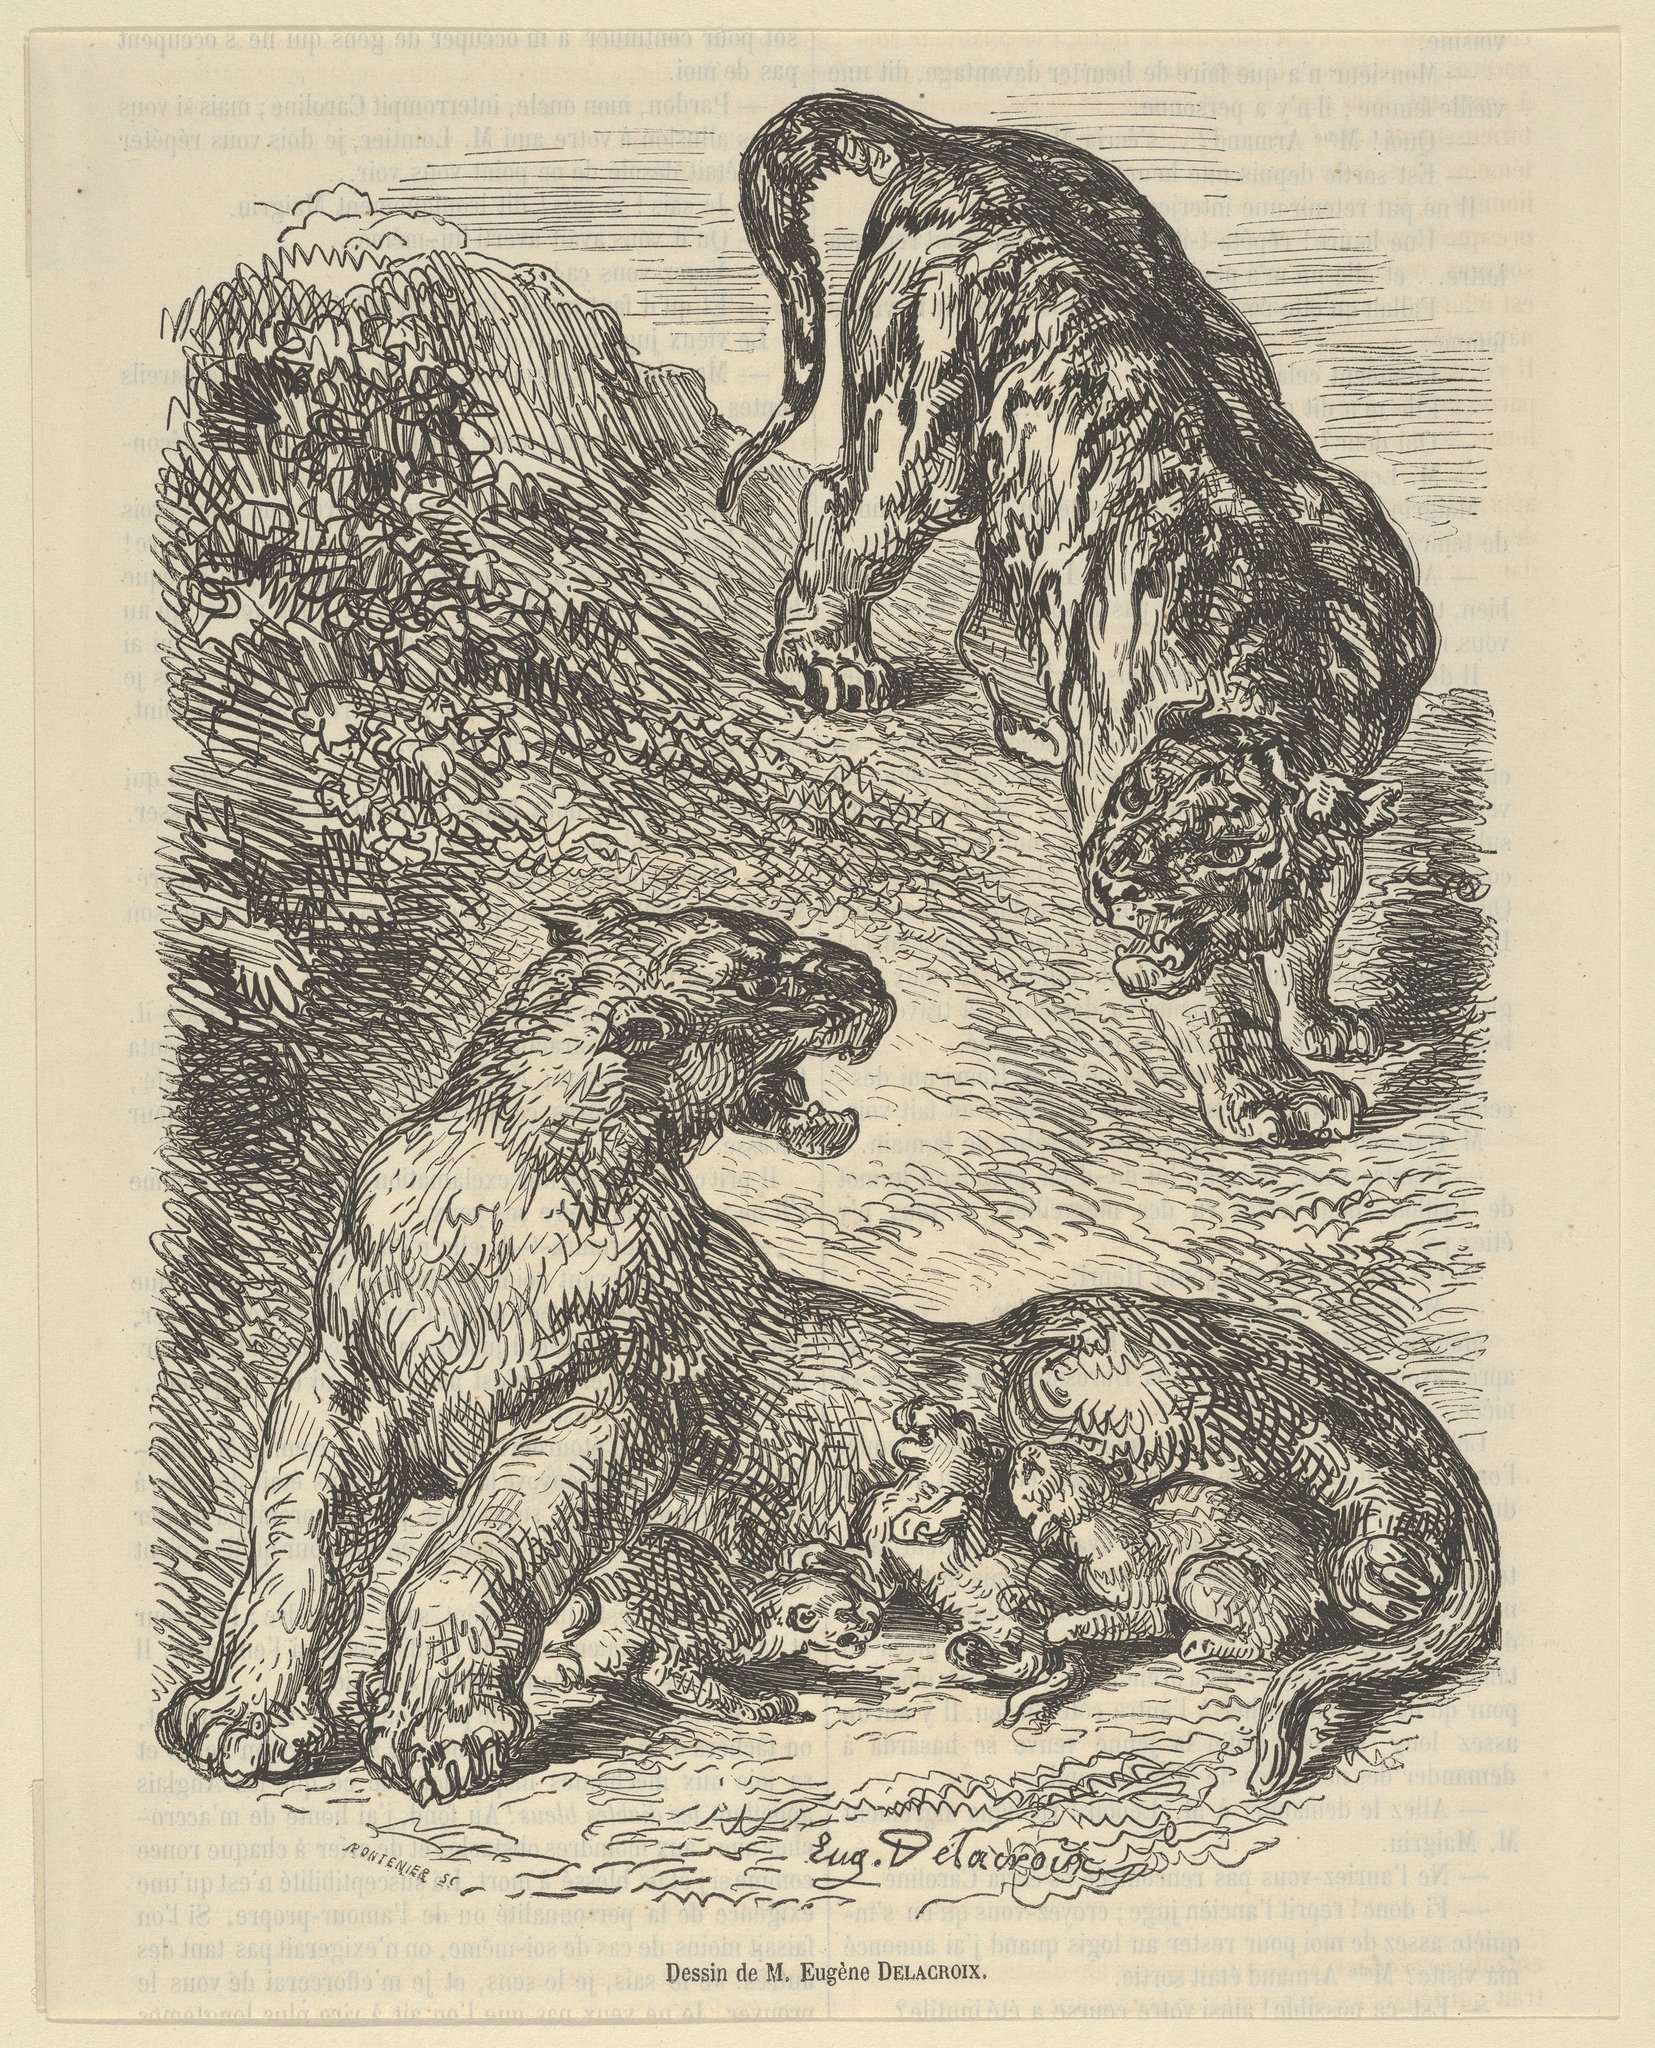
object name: print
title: Tigress Attacked by a Tiger While Nursing her Young, from "Le Magasin Pittoresque"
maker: eugène delacroix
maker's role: artist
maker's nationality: french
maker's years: 1798-1863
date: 1853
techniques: engraving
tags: tigers